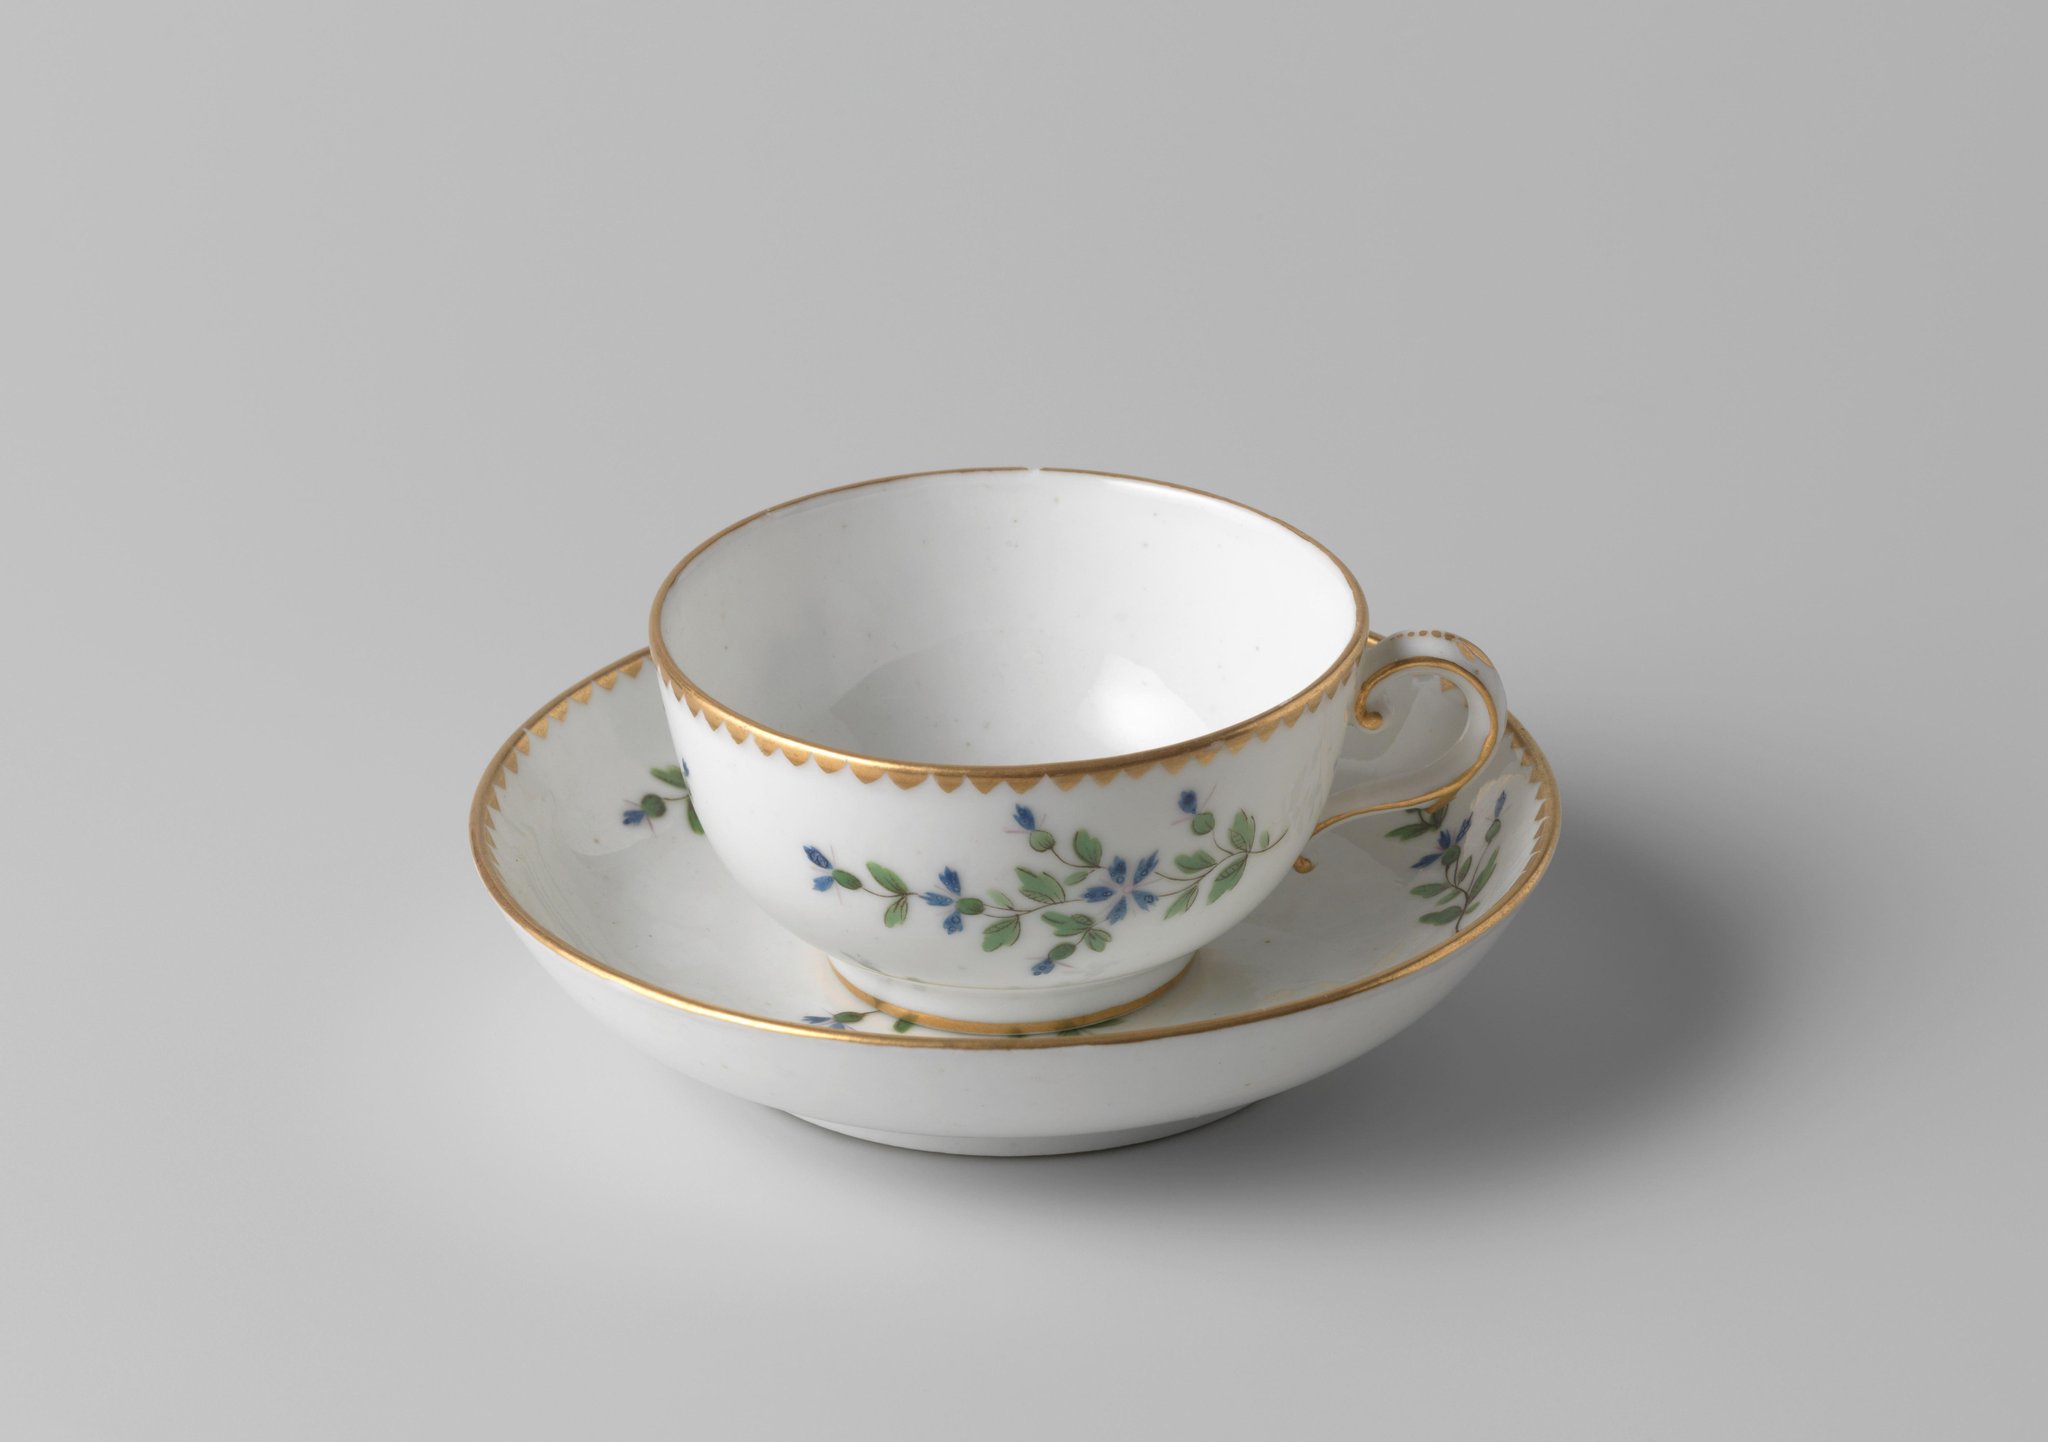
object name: cup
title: Cup with flower sprays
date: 1790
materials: glaze, gold, paint, porcelain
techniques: firing, forming, gilding, turning, vitrification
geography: lille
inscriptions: mark: ‘gekroonde dolfijn’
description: Kop van porselein met een C-vormig oor, beschilderd op het glazuur in blauw, roze, groen, zwart en goud. De buitenwand met bloemtakken (korenbloem). Gouden lijn op de voet en een band met driehoeken op de rand. Het oor is aangezet met gouden stippen en plantmotieven. Gemerkt op de onderzijde met de gekroonde dolfijn.